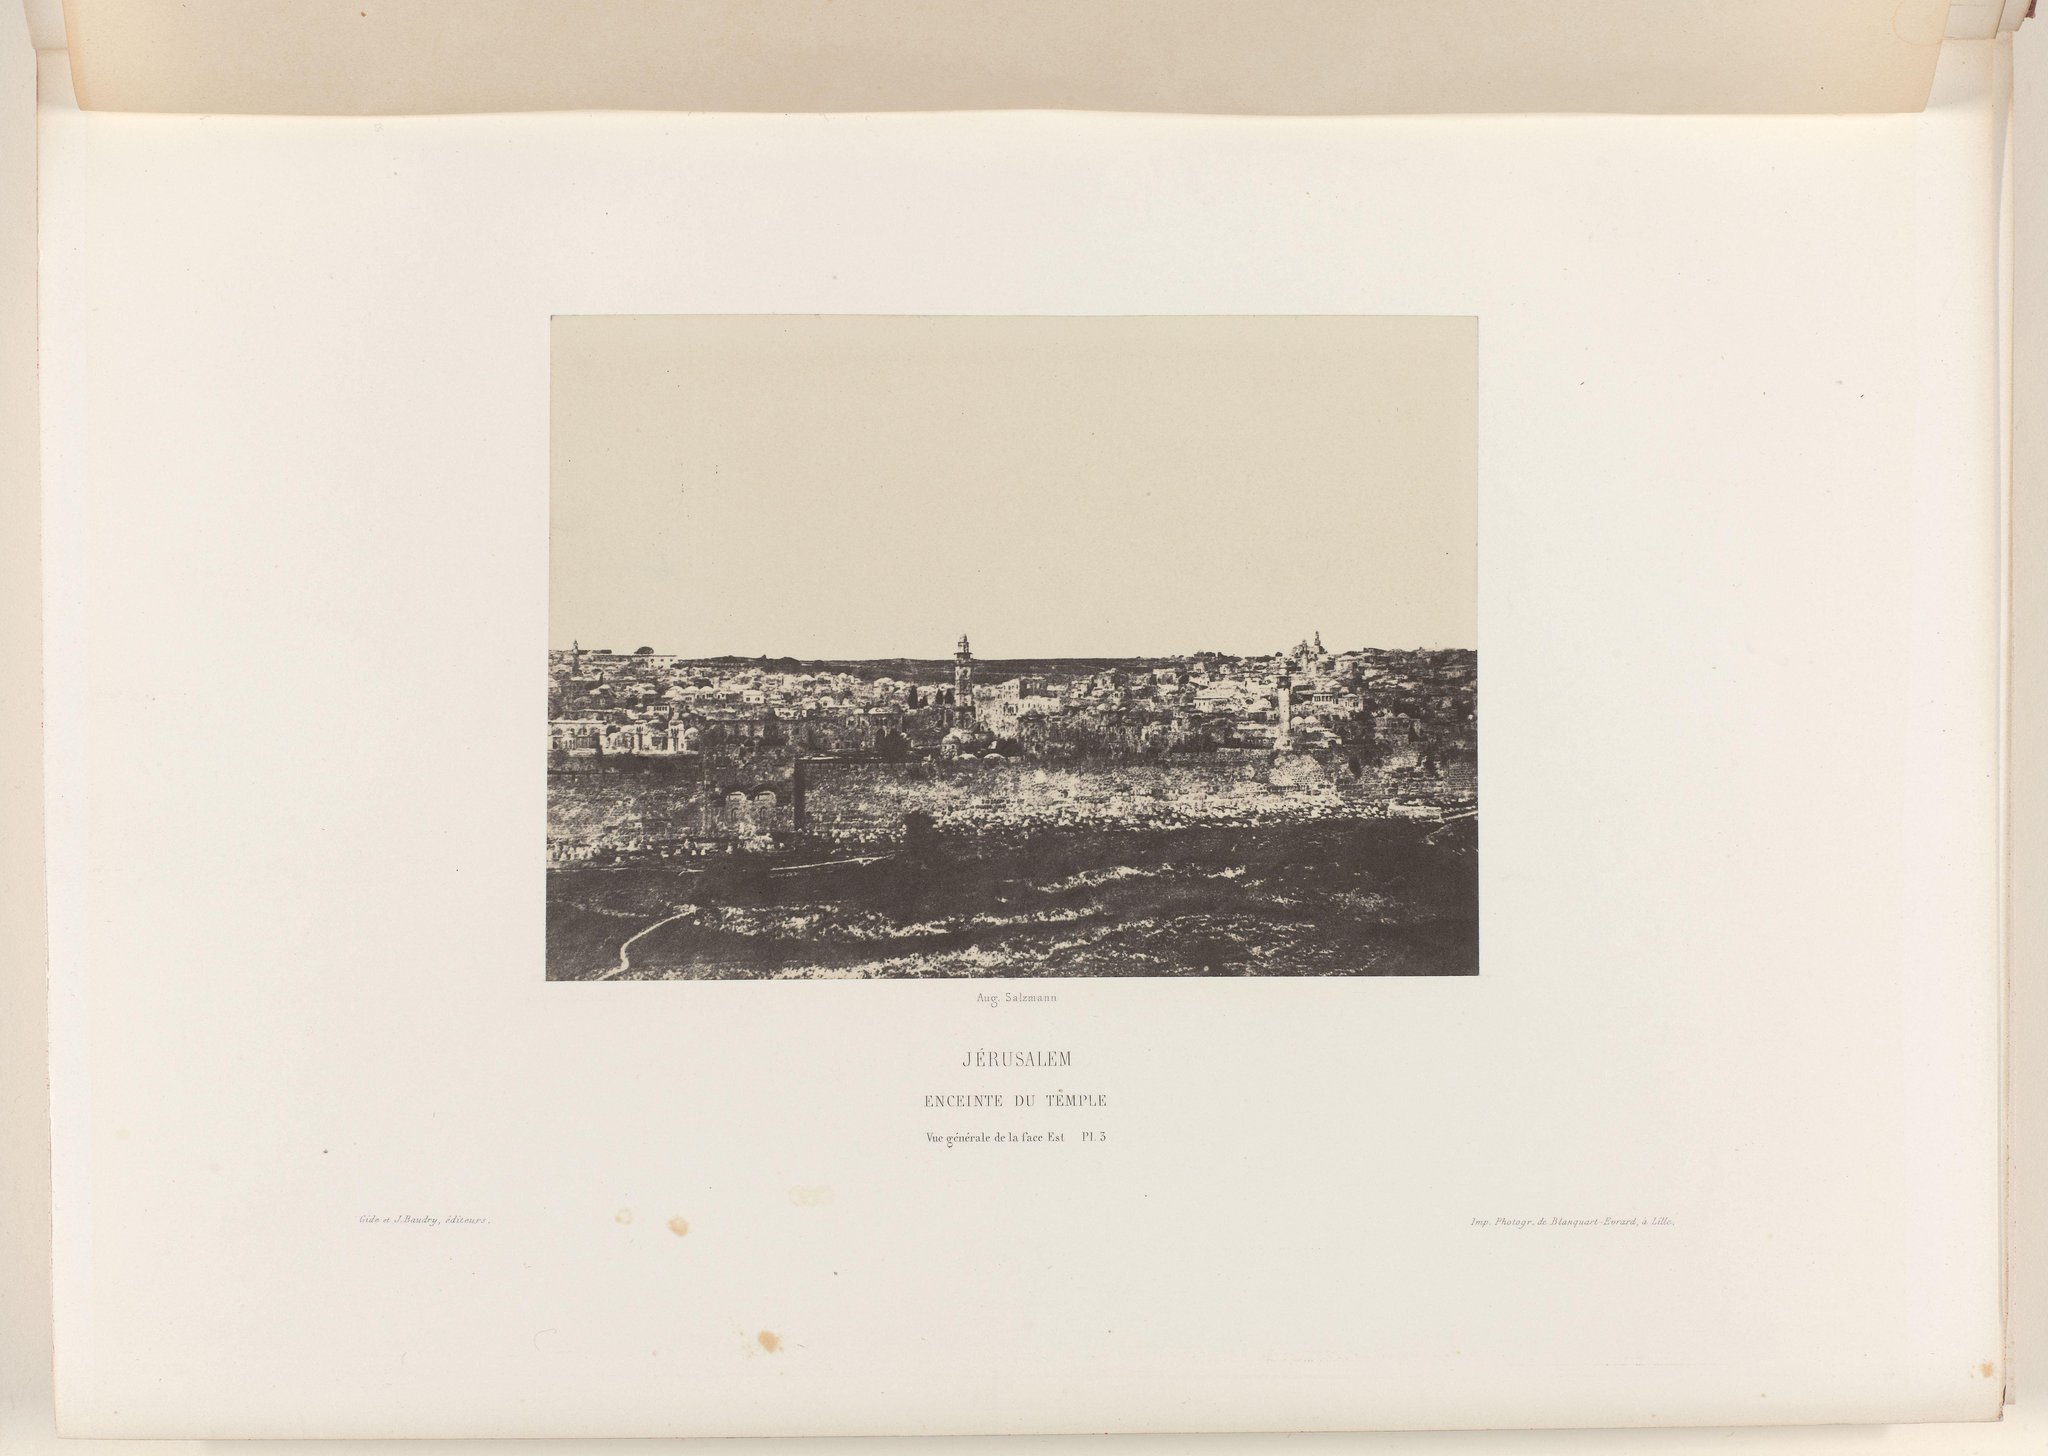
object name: photograph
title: Gezicht op Jeruzalem, met de ommuring van de tempel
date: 1854-1856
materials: cardboard, paper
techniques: salted paper print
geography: jerusalem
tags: city-view in general; 'veduta', fence, wall, paling